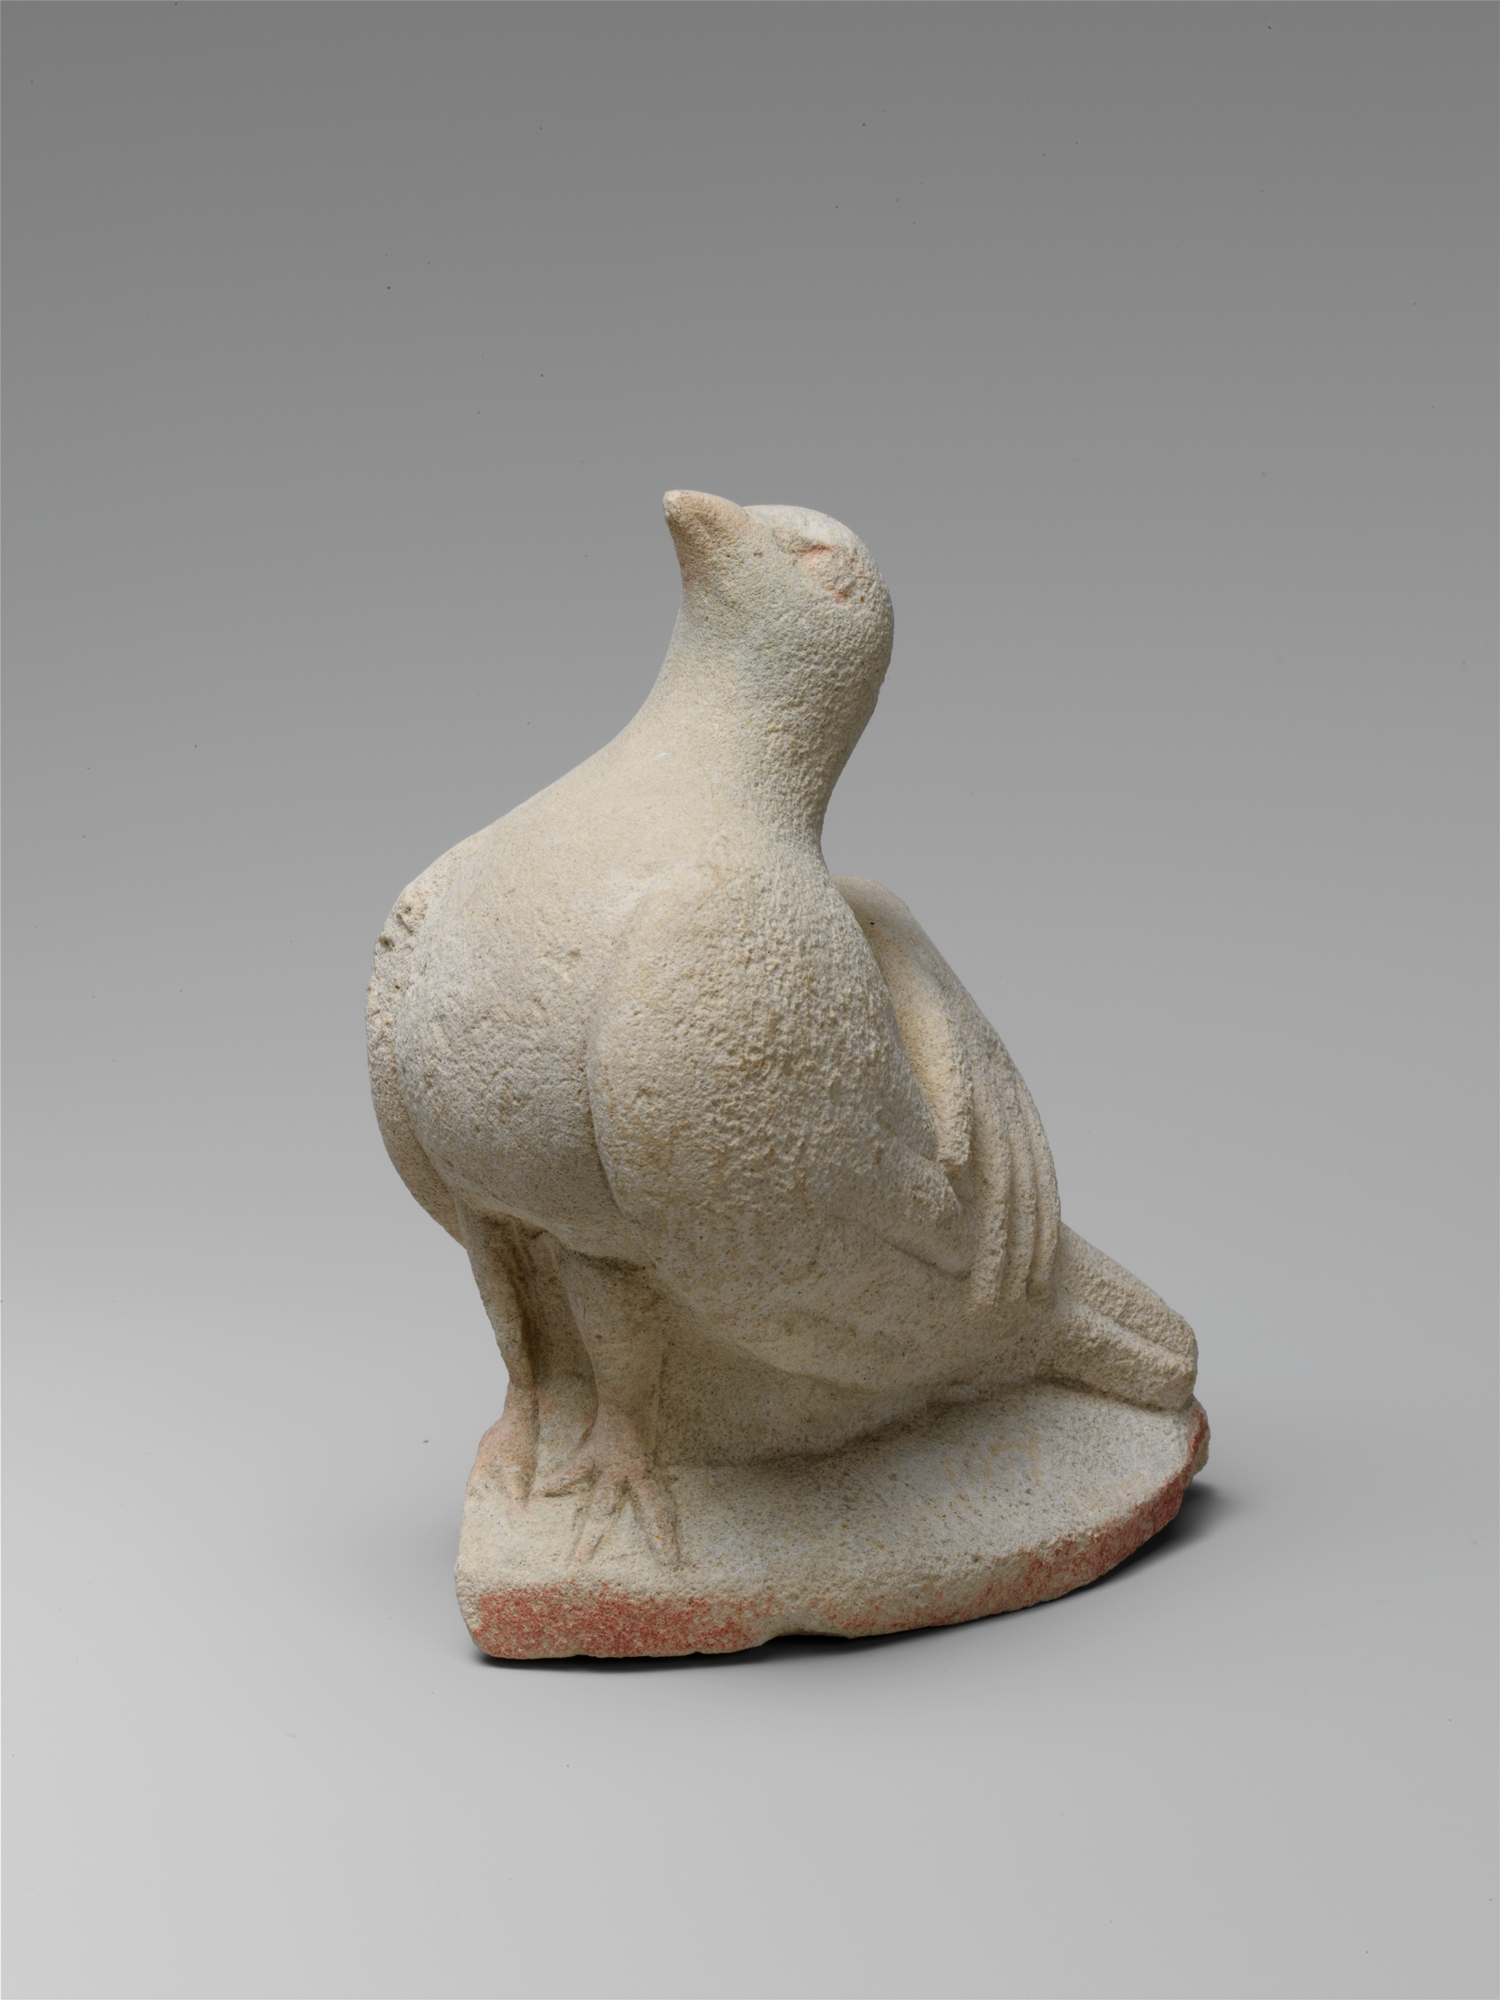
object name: statue fragment of a left hand resting on a dove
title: Limestone statue fragment of a left hand resting on a dove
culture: cypriot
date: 300-1 BCE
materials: limestone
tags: doves,hands